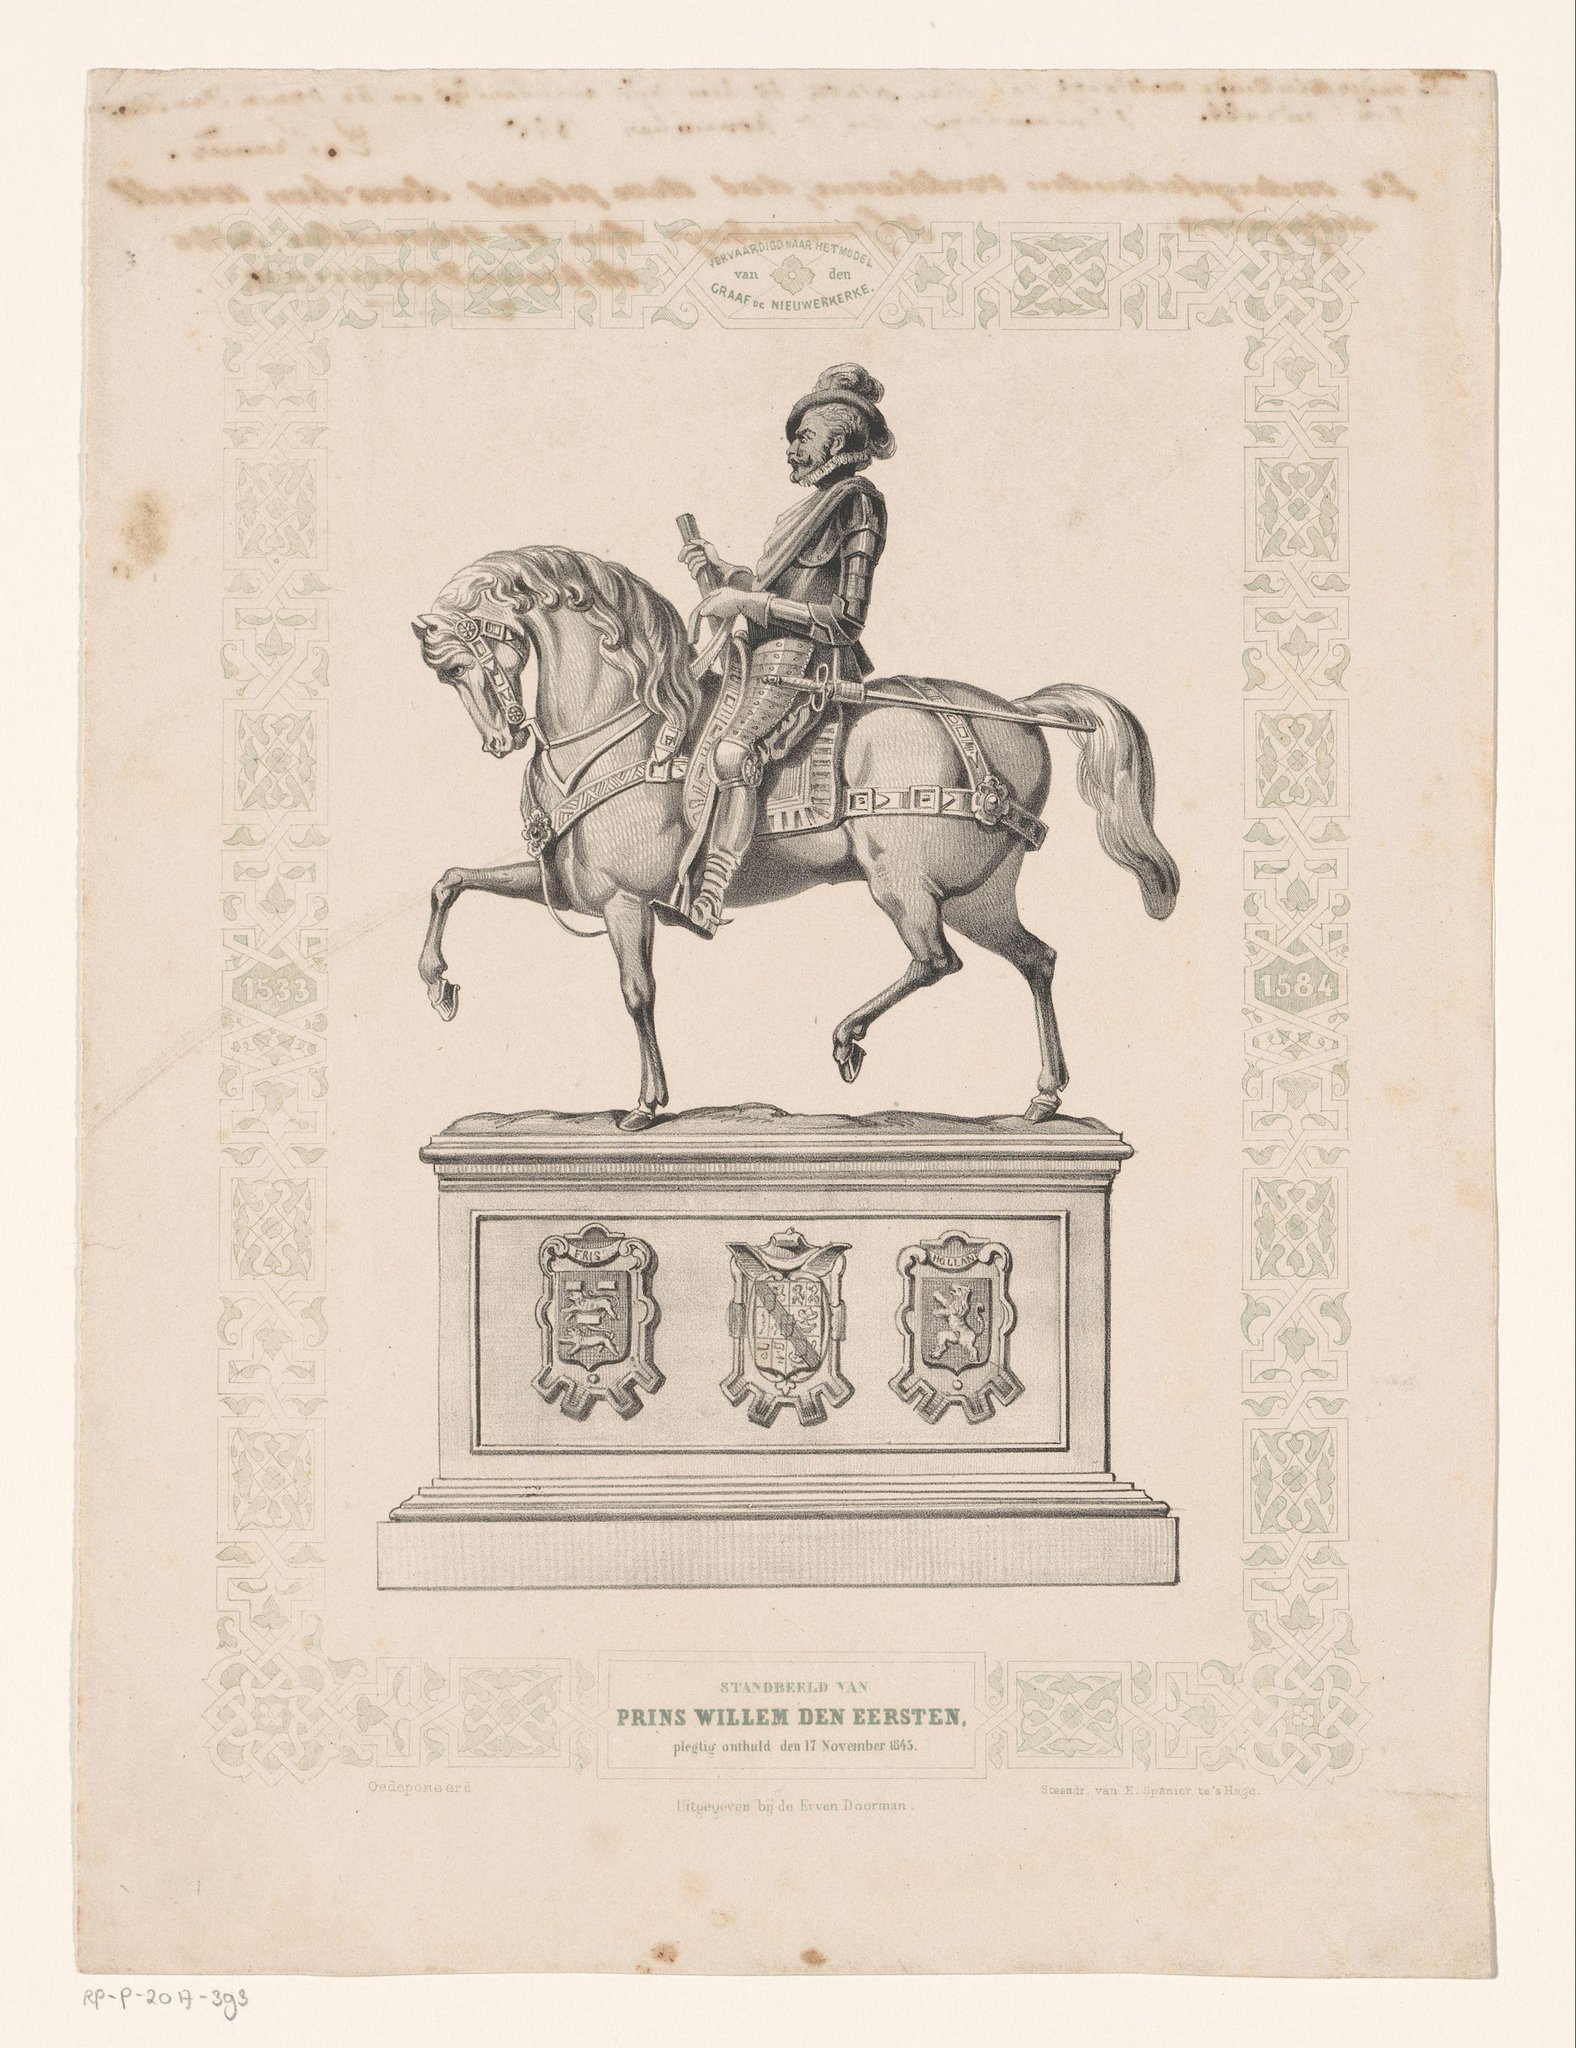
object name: print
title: Ruiterstandbeeld van Willem van Oranje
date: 1845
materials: paper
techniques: lithograph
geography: the hague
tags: william i (prince of orange), equestrian statue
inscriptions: : ‘De ondergeteekende verklaart dat deze platen bij hem zijn vervaardigd en ter zijner steendrukkerij / zijn gedrukt. 's Gravenhage den 17 november 1845 E. Spanier’, : ‘De ondergeteekenden verklaren, dat deze plaat door hen wordt / uitgegeven 's Gravenhage den 17 november 1846 / De ervan Doorman’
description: Zijaanzicht van het standbeeld, door Émile de Nieuwerkerke uit 1845 in Den Haag, bij Paleis Noordeinde.